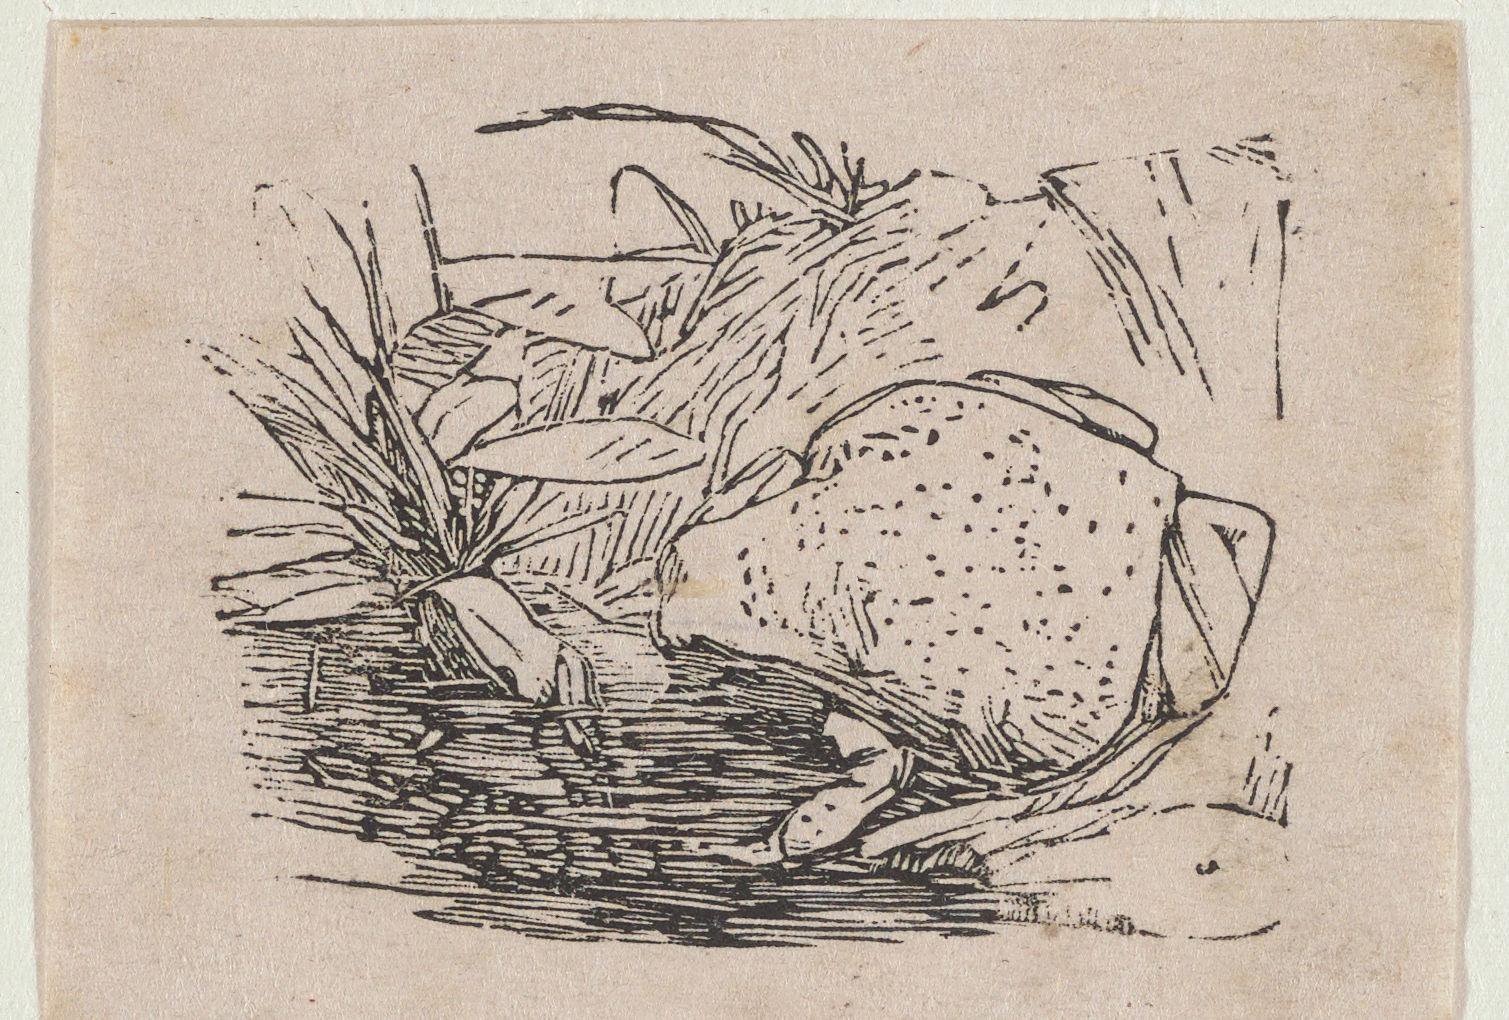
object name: print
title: Waterkant met planten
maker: isaac weissenbruch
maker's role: print maker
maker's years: 1826-1912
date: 1836-1912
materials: paper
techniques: engraving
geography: netherlands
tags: plants; vegetation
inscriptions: collector's mark: Lugt 2228